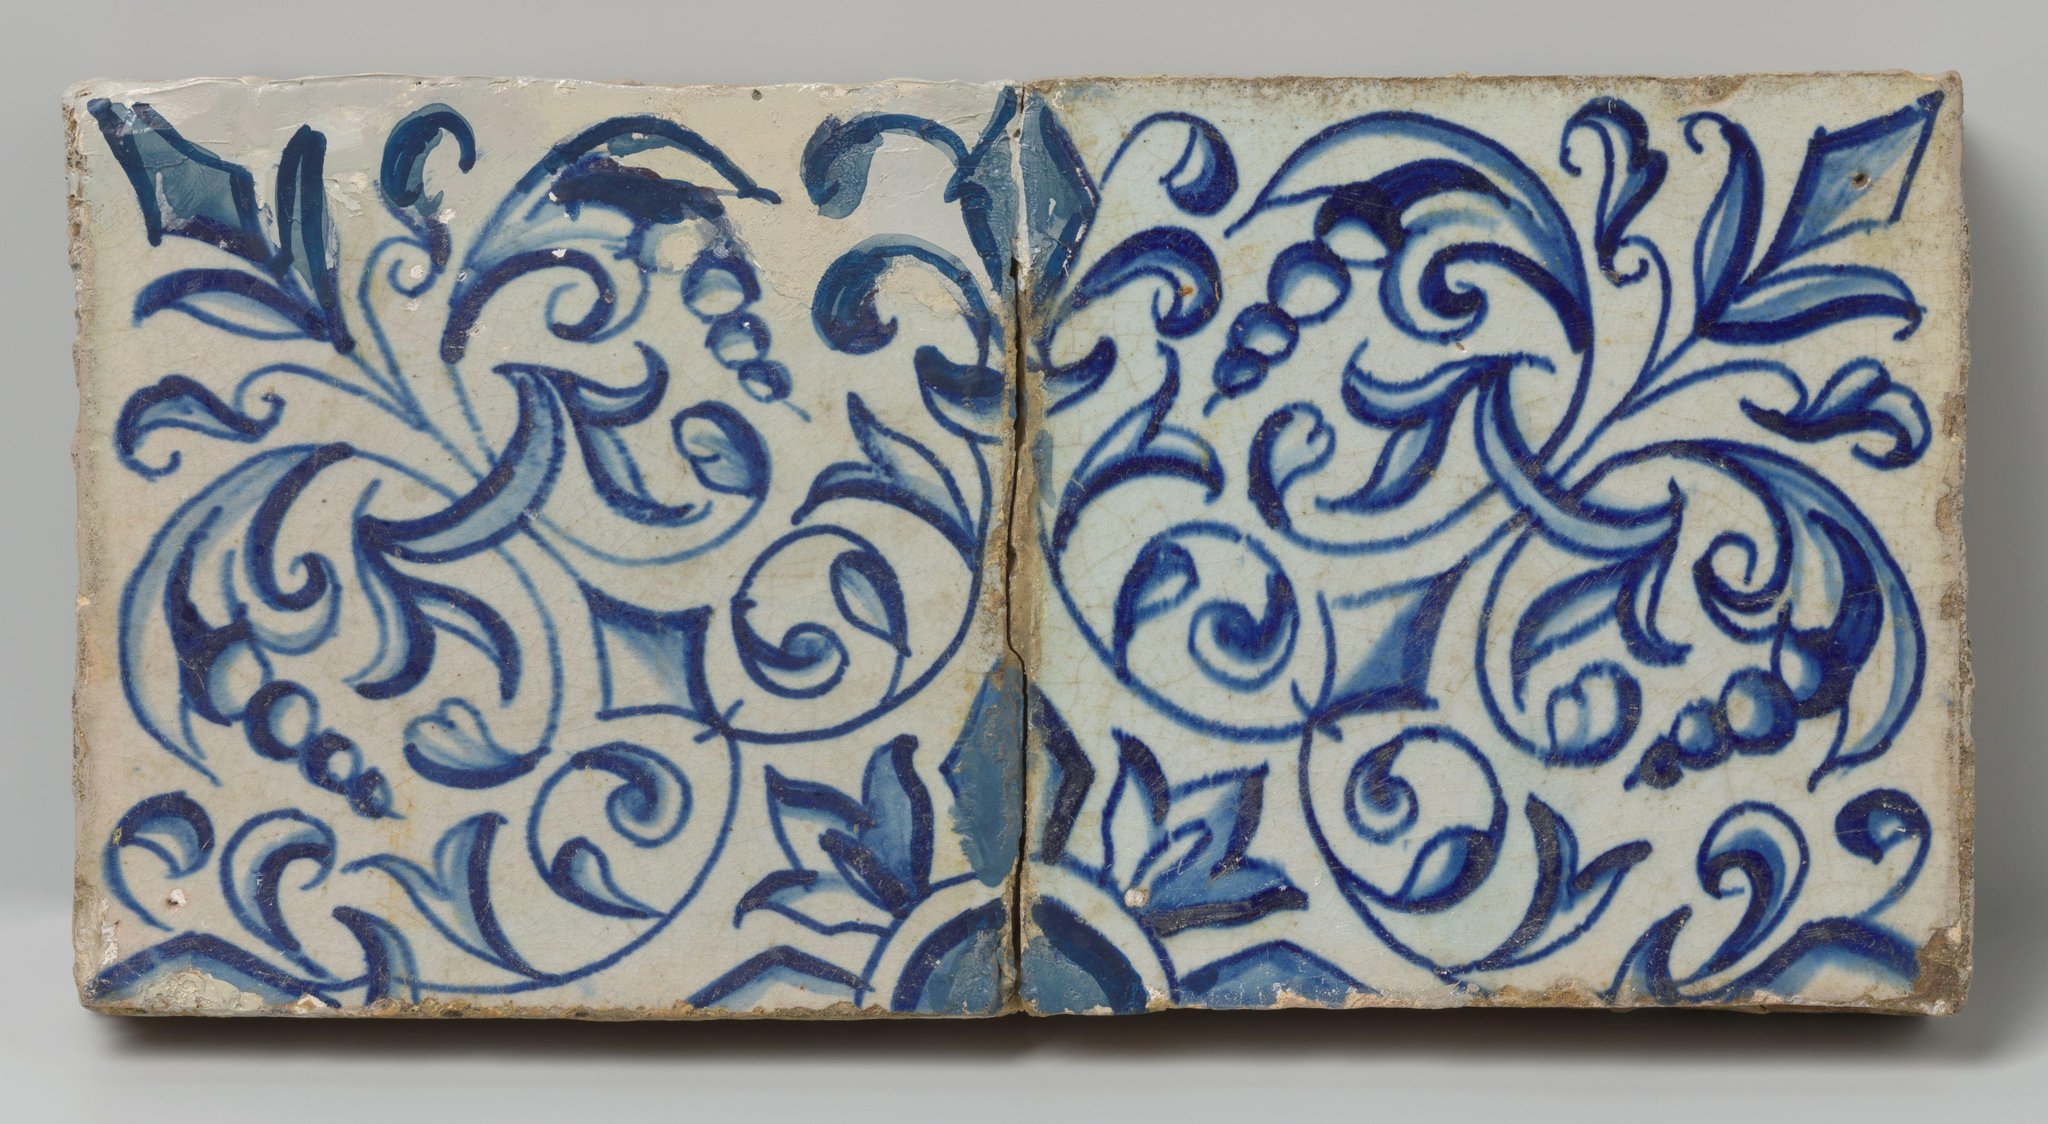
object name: tile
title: Veld van twee tegels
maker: Anonymous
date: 1610-1635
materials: earthenware, glaze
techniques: maiolica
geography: netherlands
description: Veld van twee tegels elk met een blauw geschilderd ornament van gestileerde bladpatronen. In één van de vier hoeken, een kwart rozet.